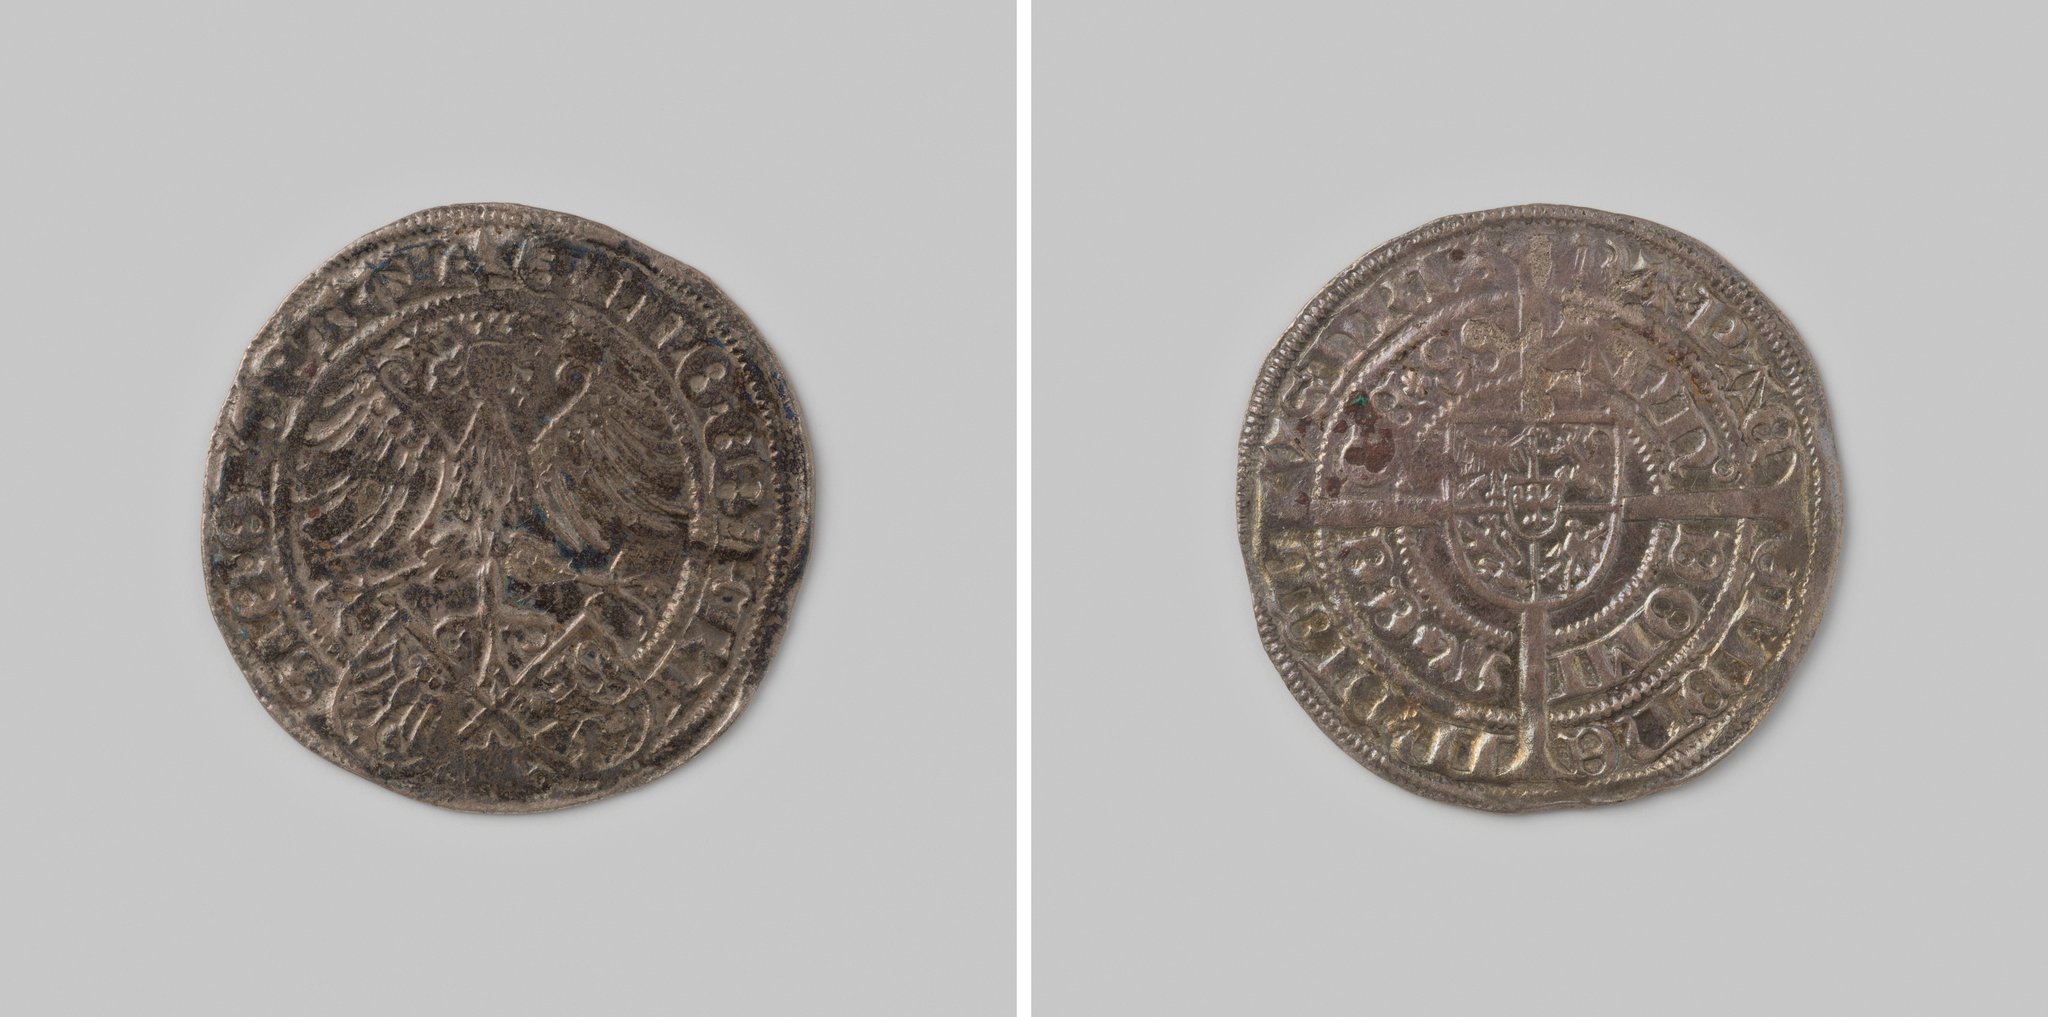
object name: coin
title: Graafschap Oost-Friesland, Enno I, doppelgrote, 1488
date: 1488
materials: silver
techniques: striking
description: Zilveren munt. Voorzijde: harpij, onder haar twee naar elkaar toegewende wapenschilden. Keerzijde: wapenschild op lang gevoet kruis. Dubbel omschrift, in binnenste omschrift jaartal in gedeeltelijk Romeinse en gedeeltelijk Arabische cijfers.